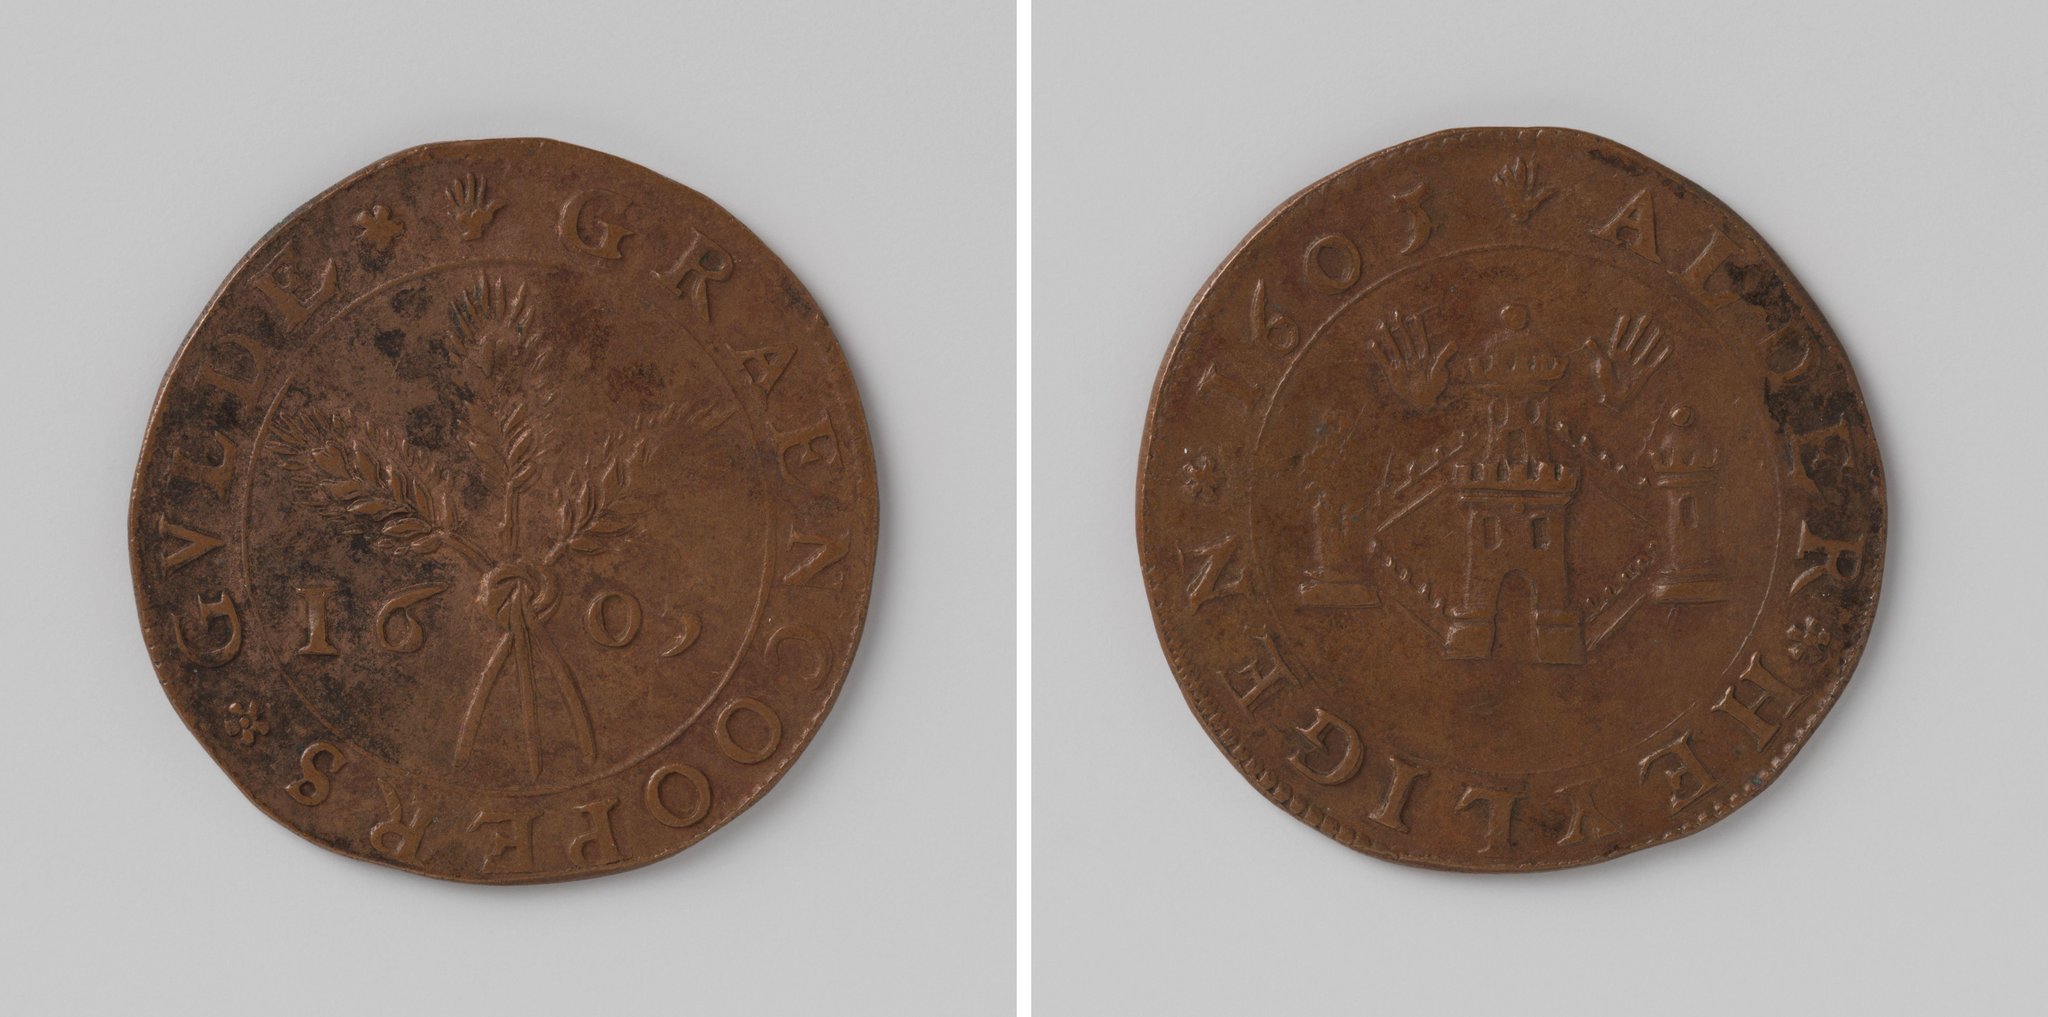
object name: medal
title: Graankopersgilde van Antwerpen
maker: Anonymous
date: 1605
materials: copper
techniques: striking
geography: antwerp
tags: antwerp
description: Koperen penning. Voorzijde: drie samengebonden korenaren tussen jaartal binnen omschrift. Keerzijde: burcht tussen twee geopende handen binnen omschrift